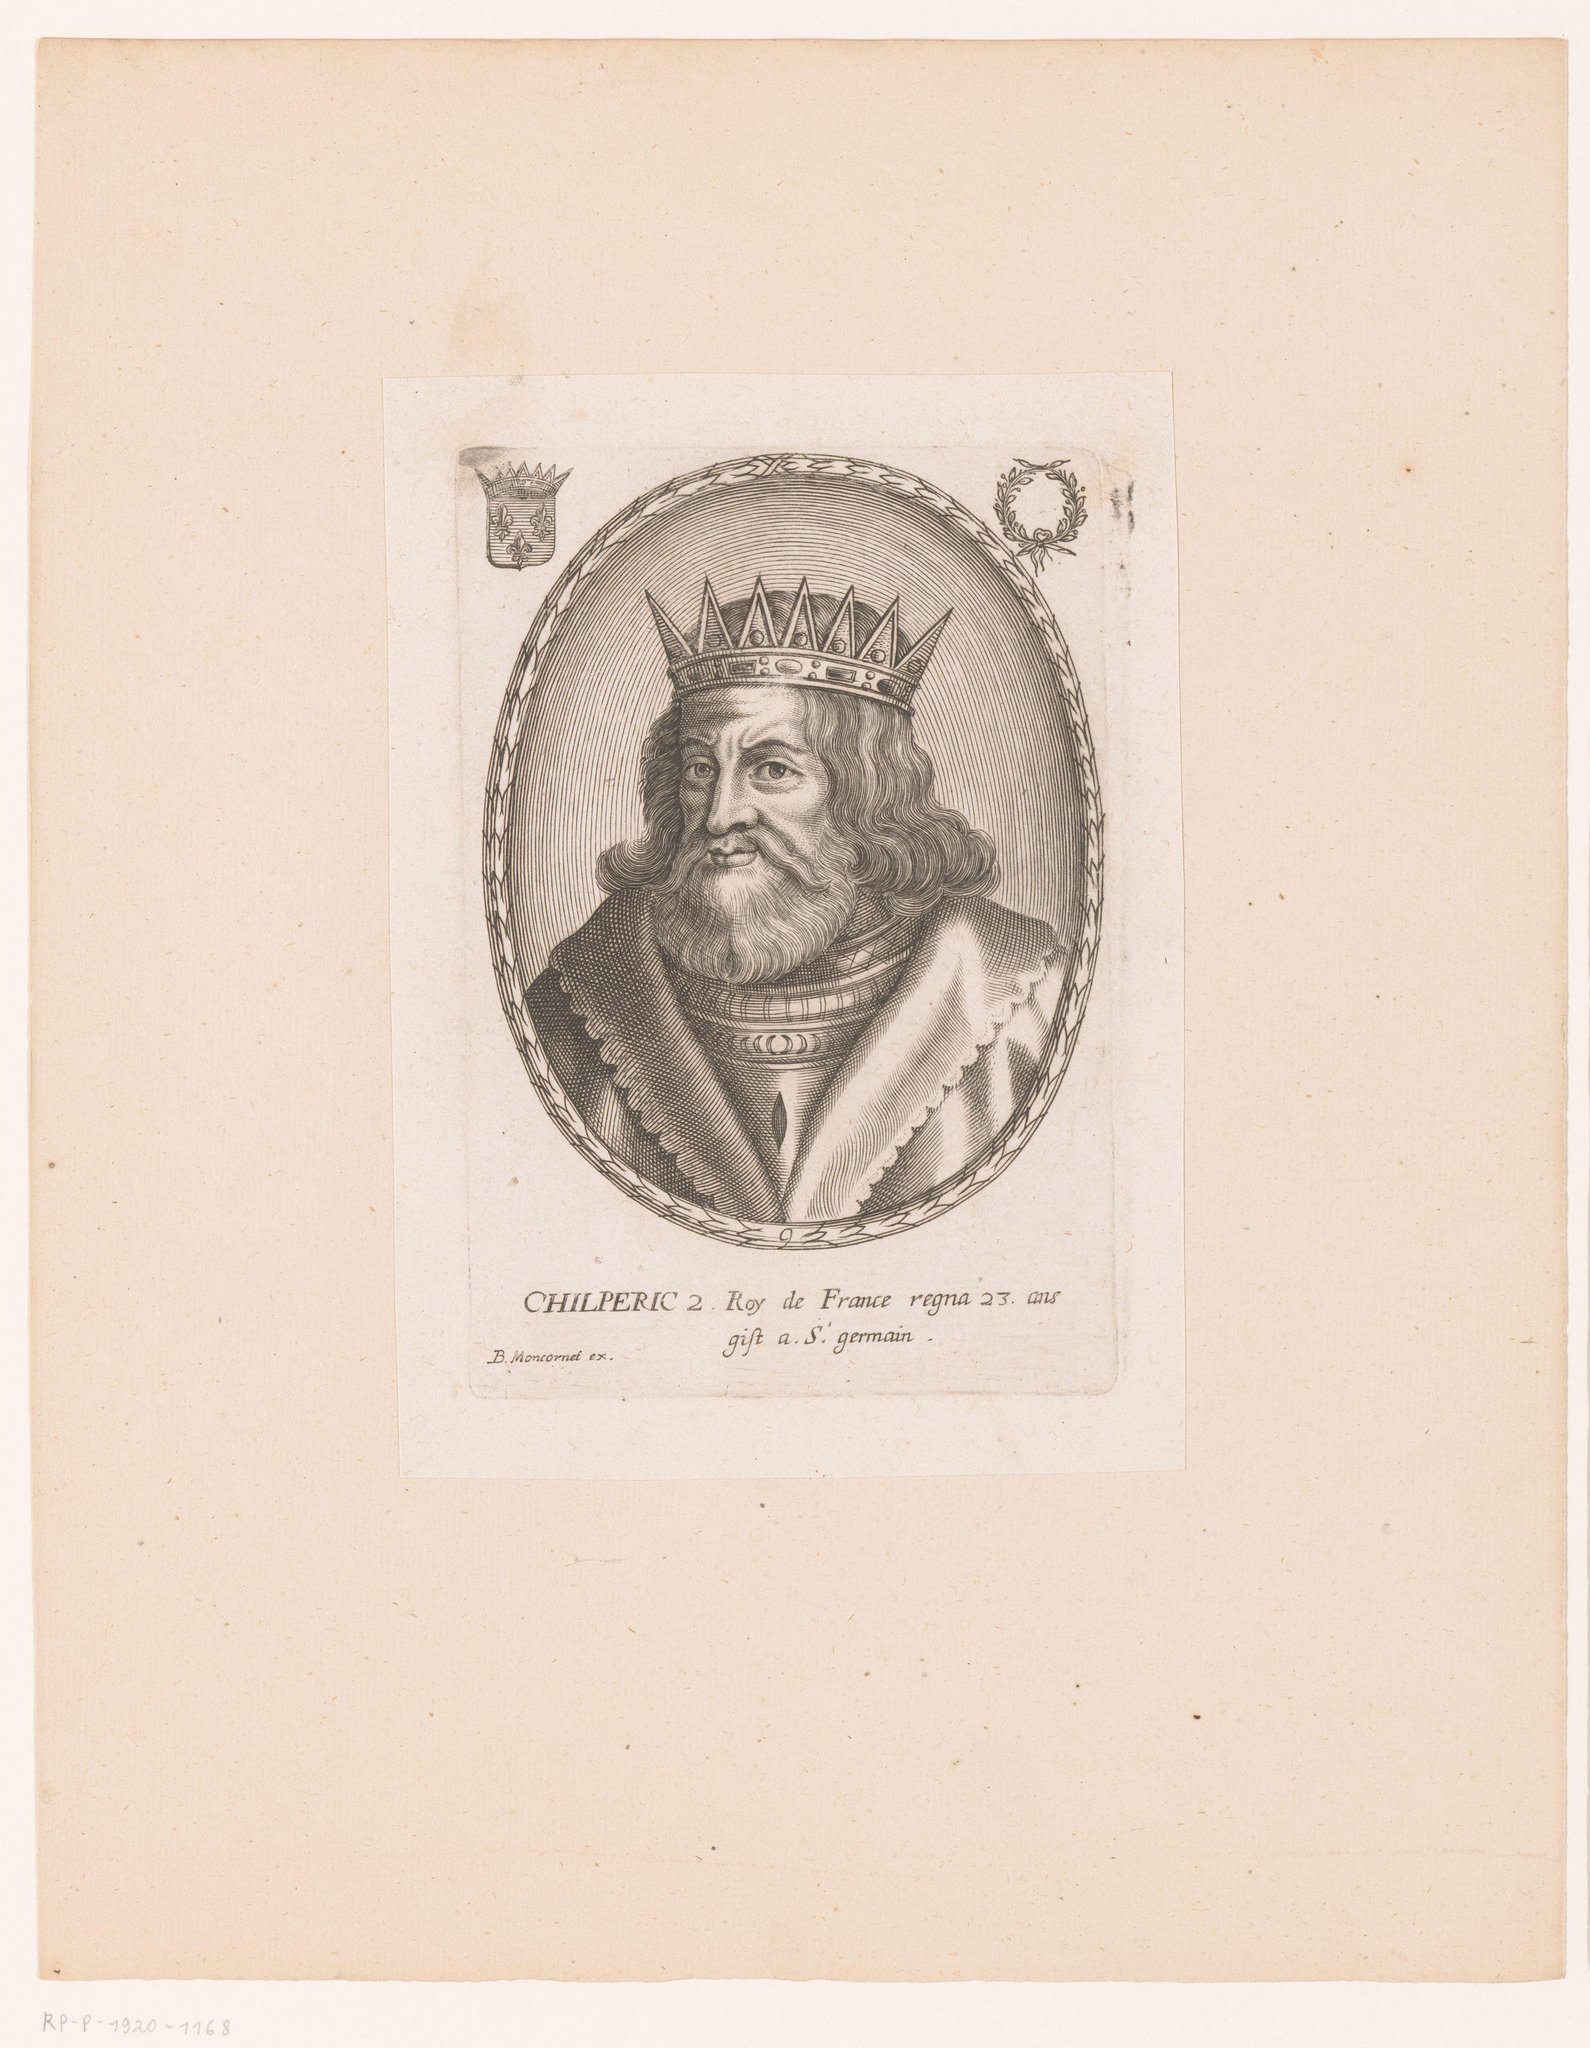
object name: print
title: Portret van Chilperik II der Franken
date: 1610-1668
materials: paper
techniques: engraving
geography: paris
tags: historical persons, king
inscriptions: collector's mark: Lugt 2228